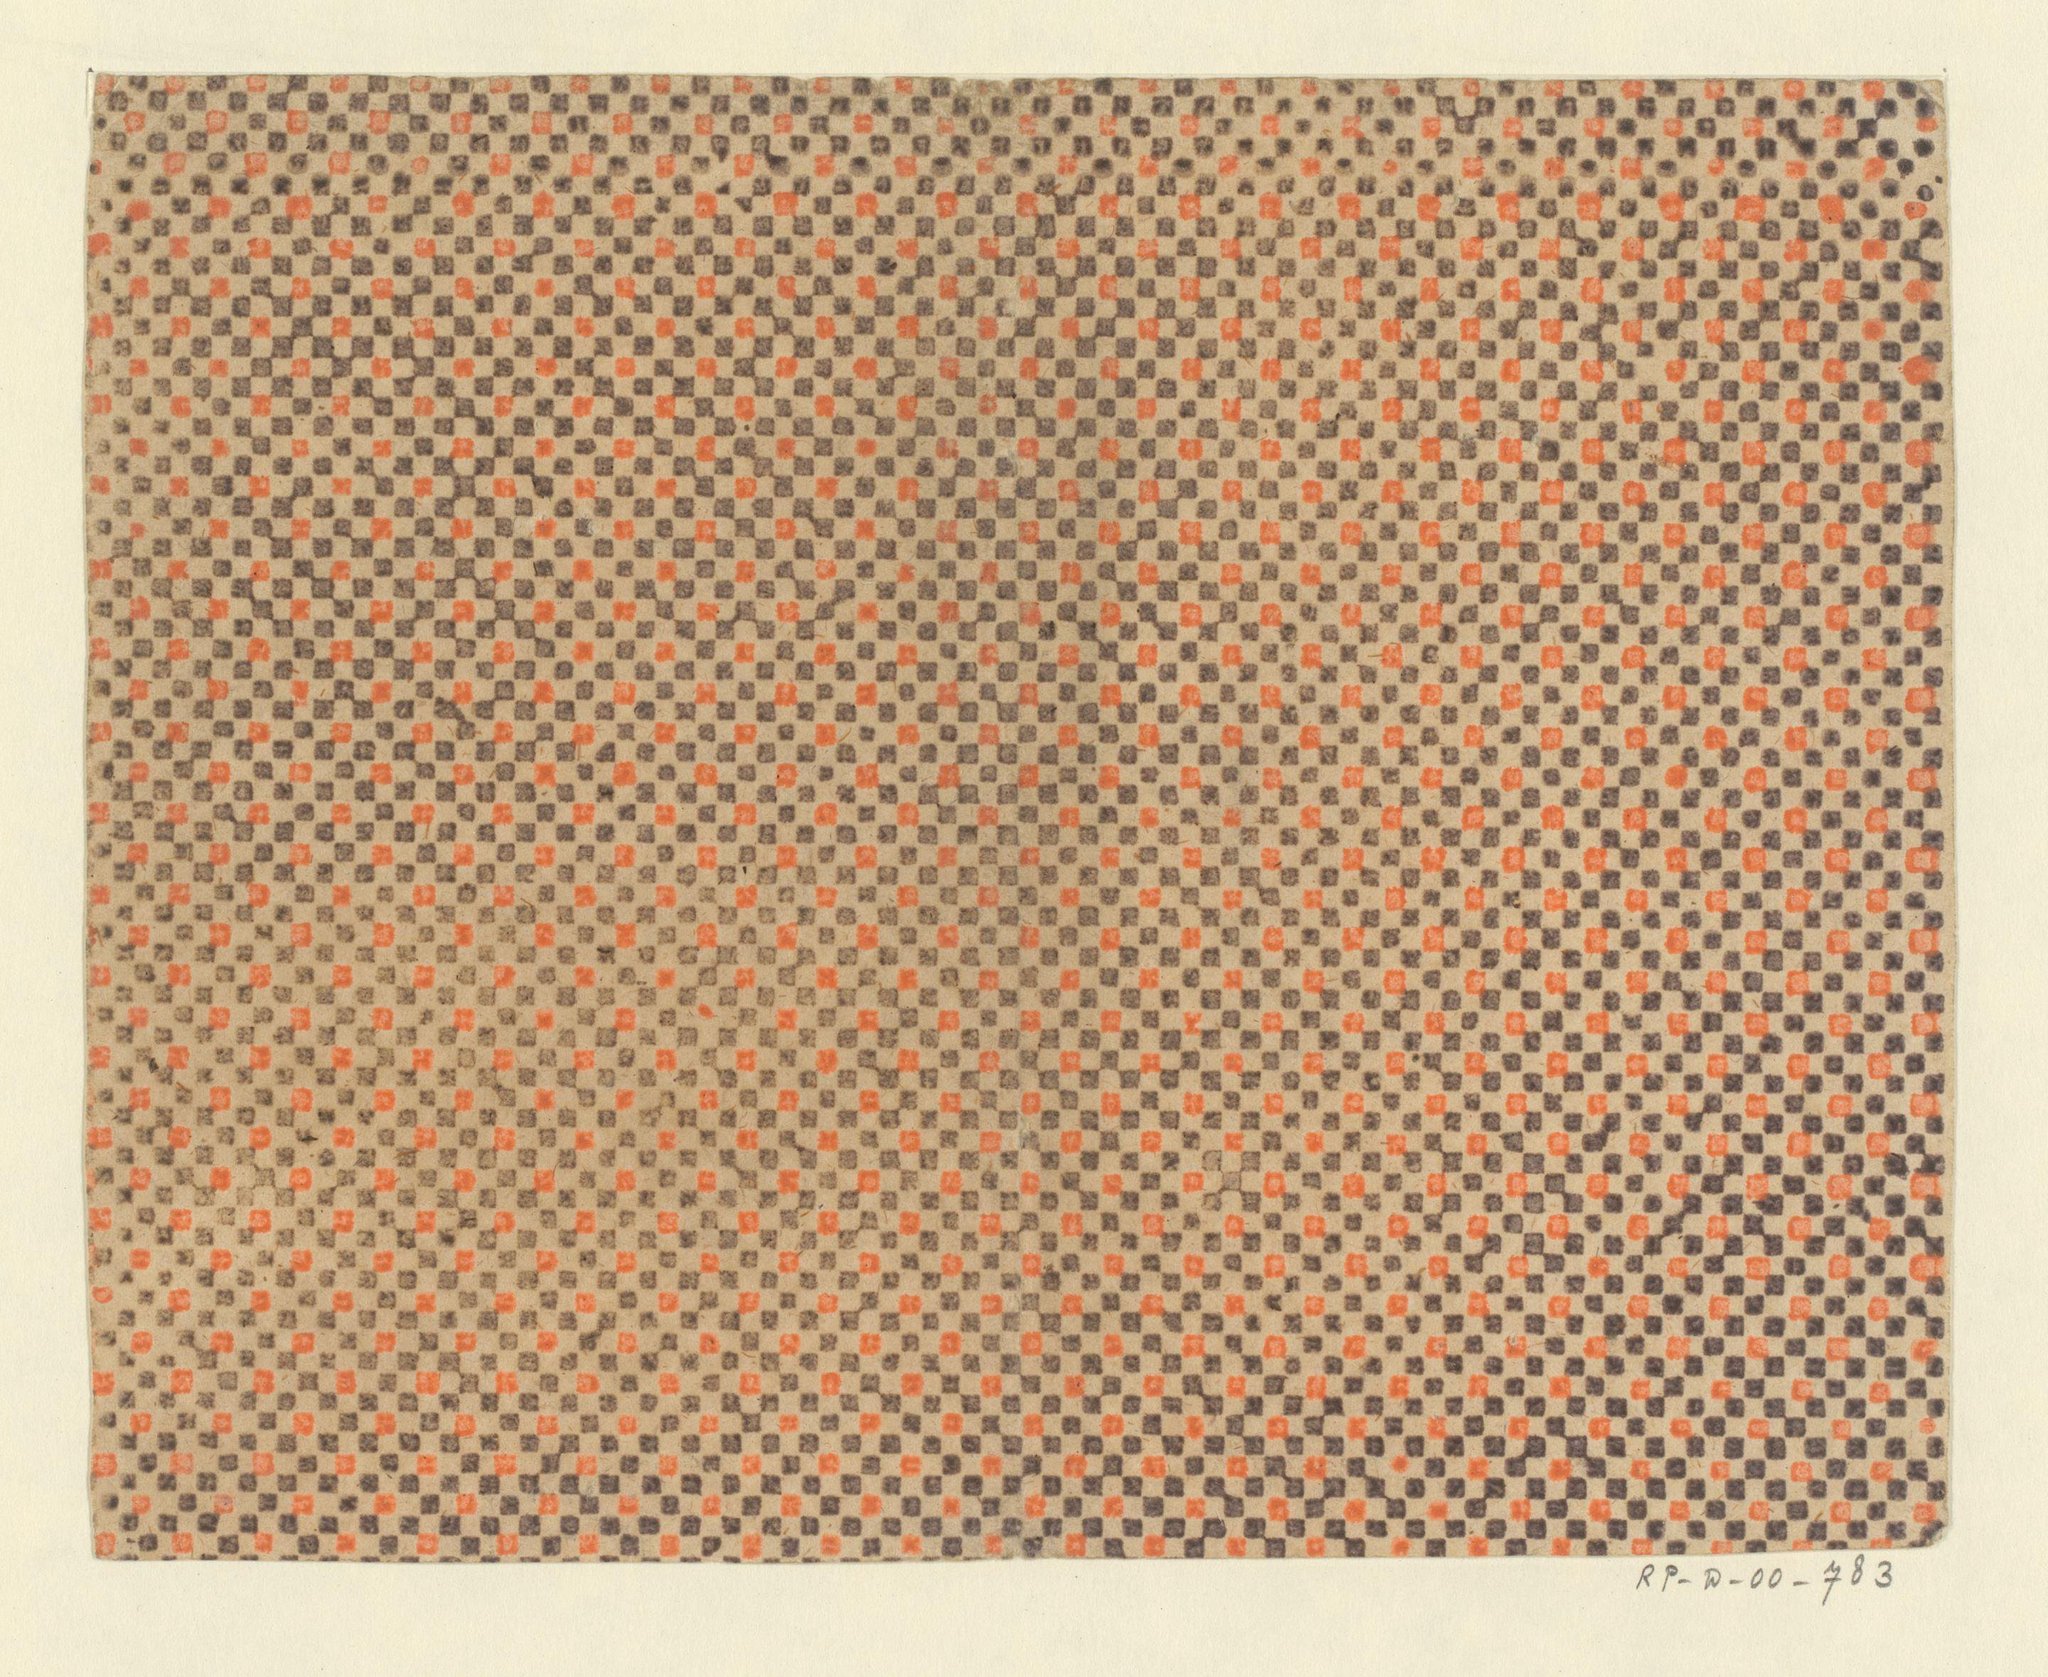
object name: printed paper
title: Blad met schaakbordpatroon van gekleurde blokjes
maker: Anonymous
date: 1750-1950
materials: paper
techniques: printing block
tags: ornament ~ straight lines (right angles only)